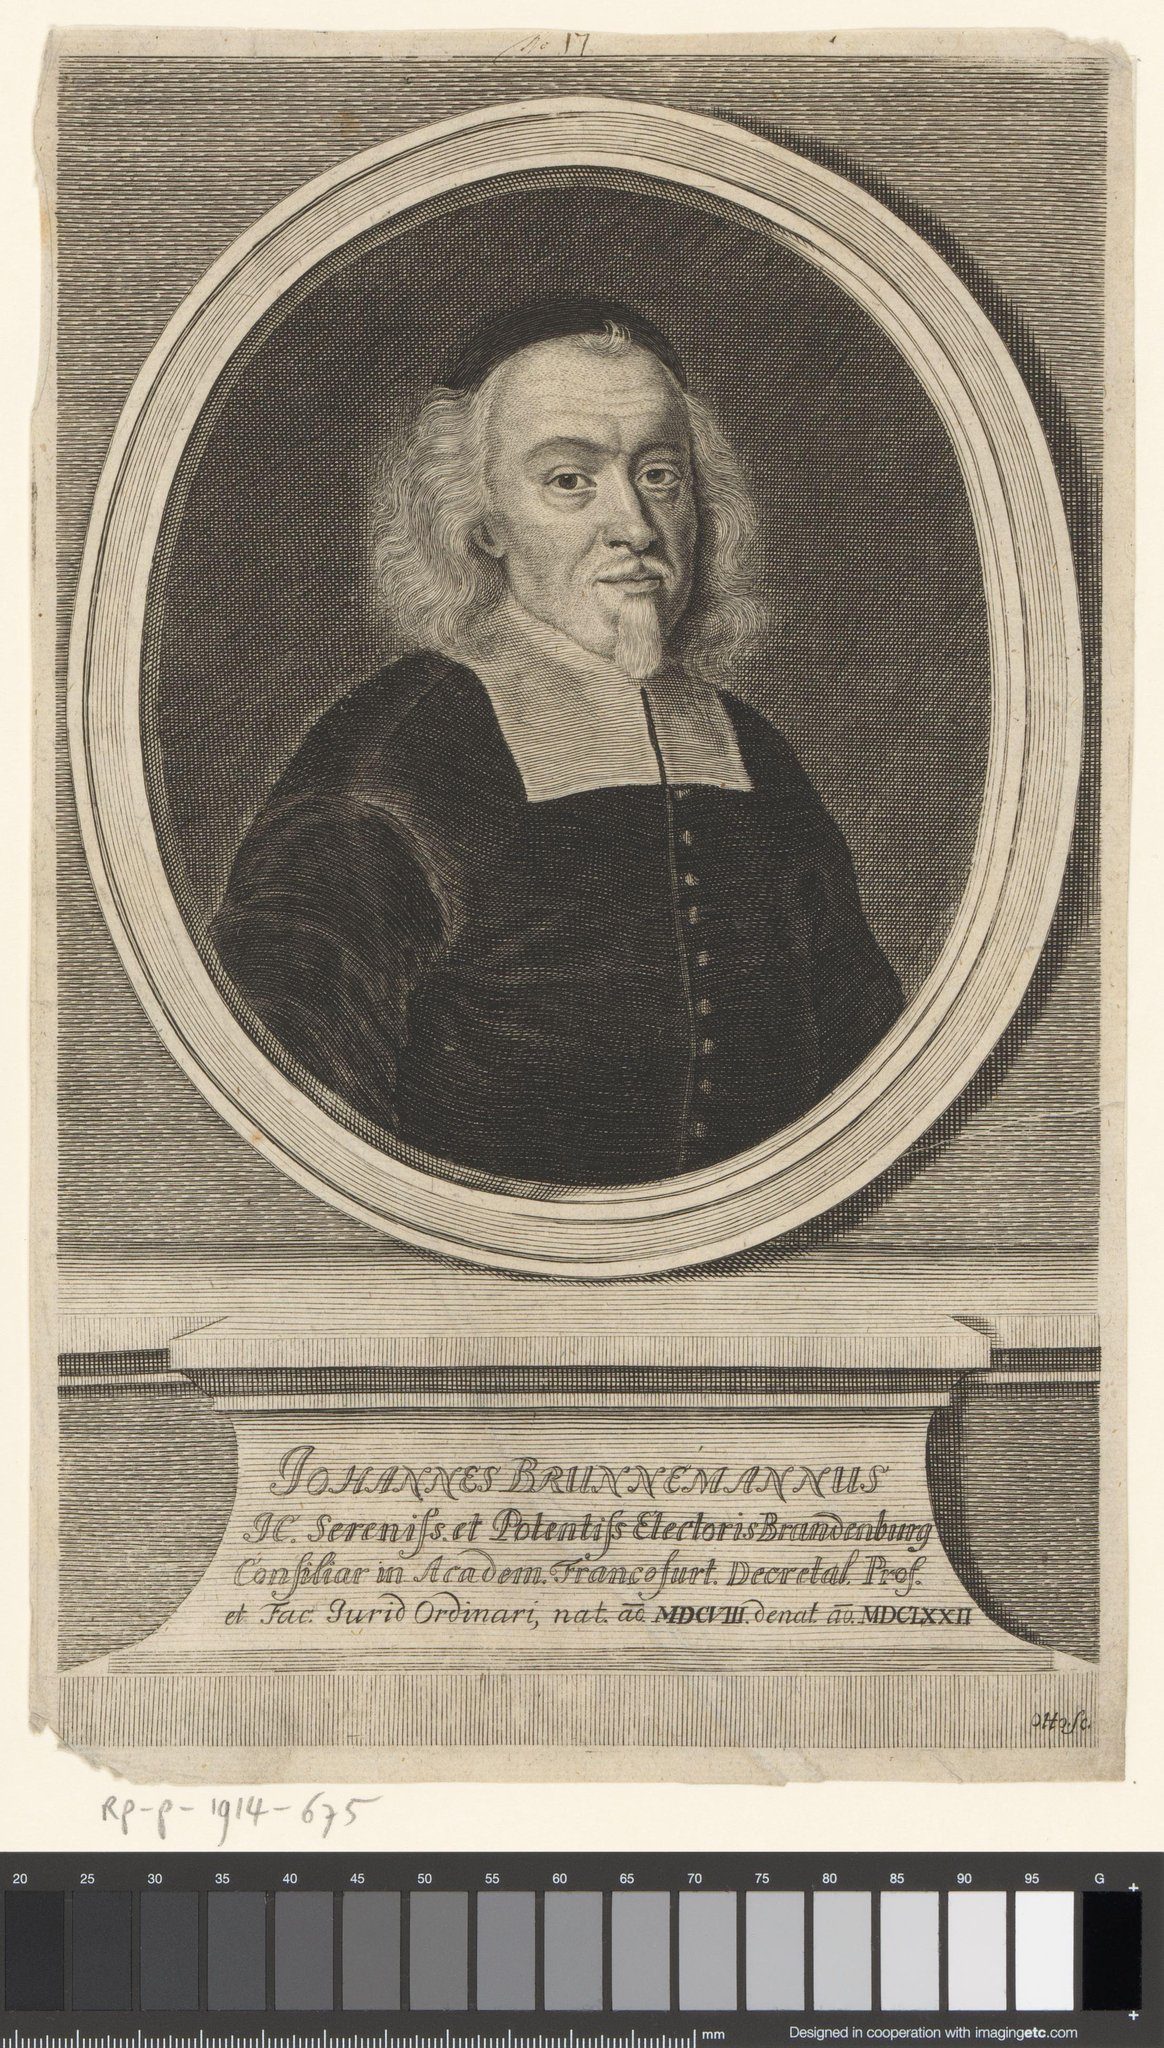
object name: print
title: Portret van Johann Brunnemann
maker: heinrich jakob otto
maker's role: print maker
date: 1672-1749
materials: paper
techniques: engraving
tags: berlin, historical persons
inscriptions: collector's mark: Lugt 2228